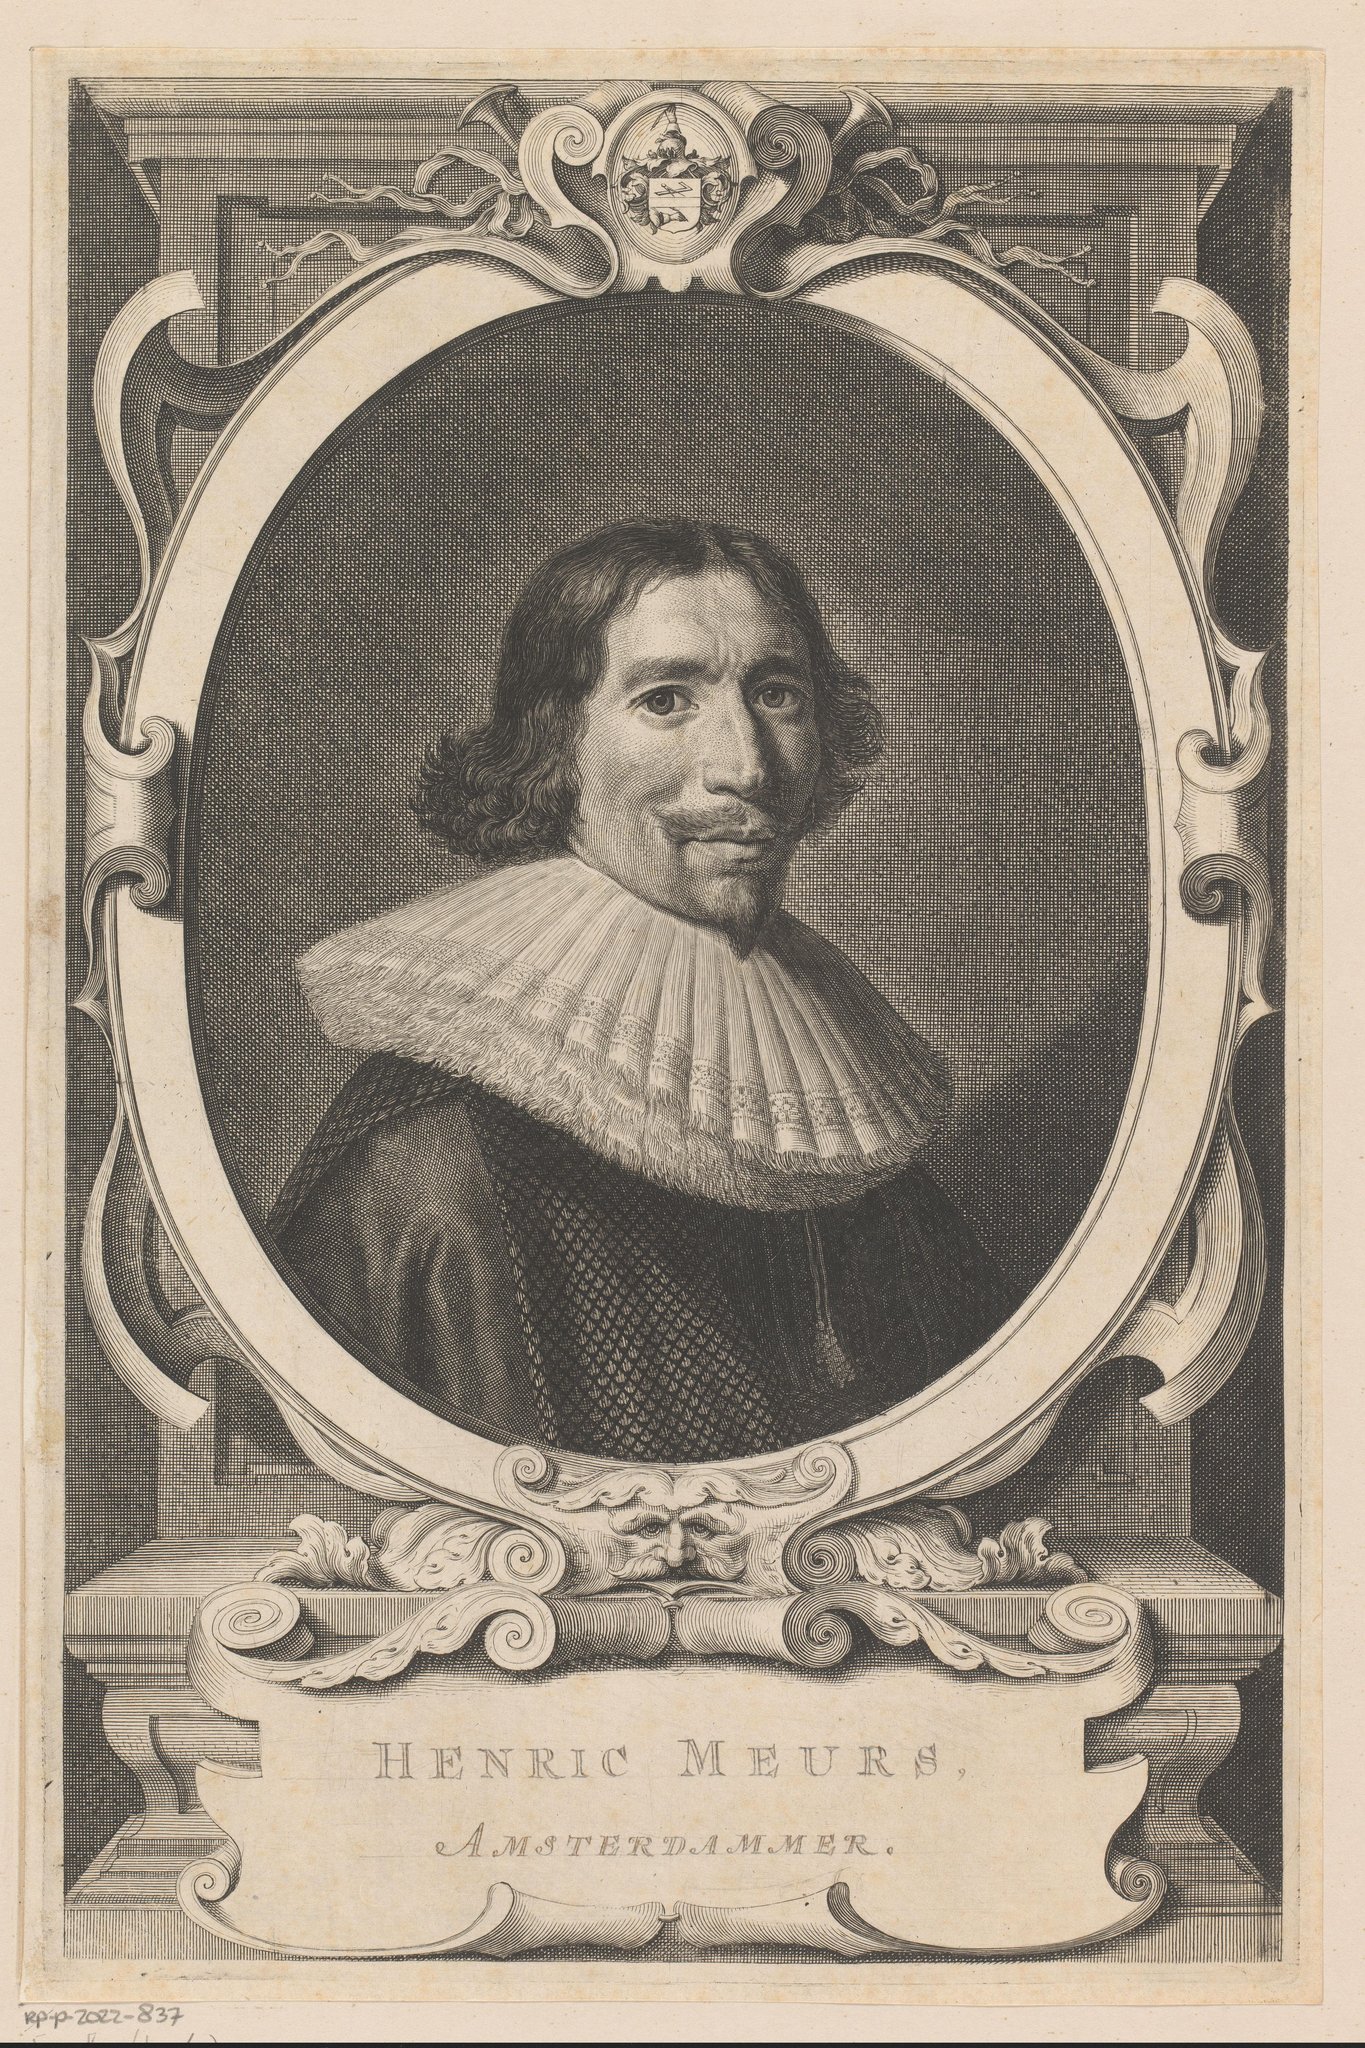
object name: print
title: Portret van Hendrik Meurs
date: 1639-1676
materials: paper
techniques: engraving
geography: northern netherlands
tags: historical persons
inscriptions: collector's mark: Lugt 963